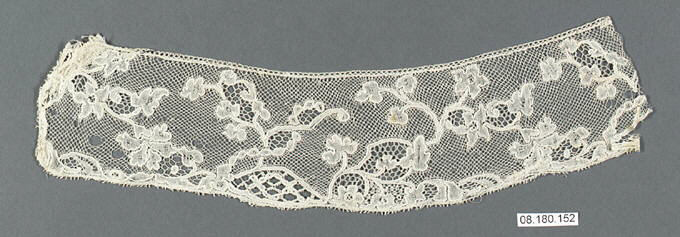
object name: piece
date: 1701-1800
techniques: lace